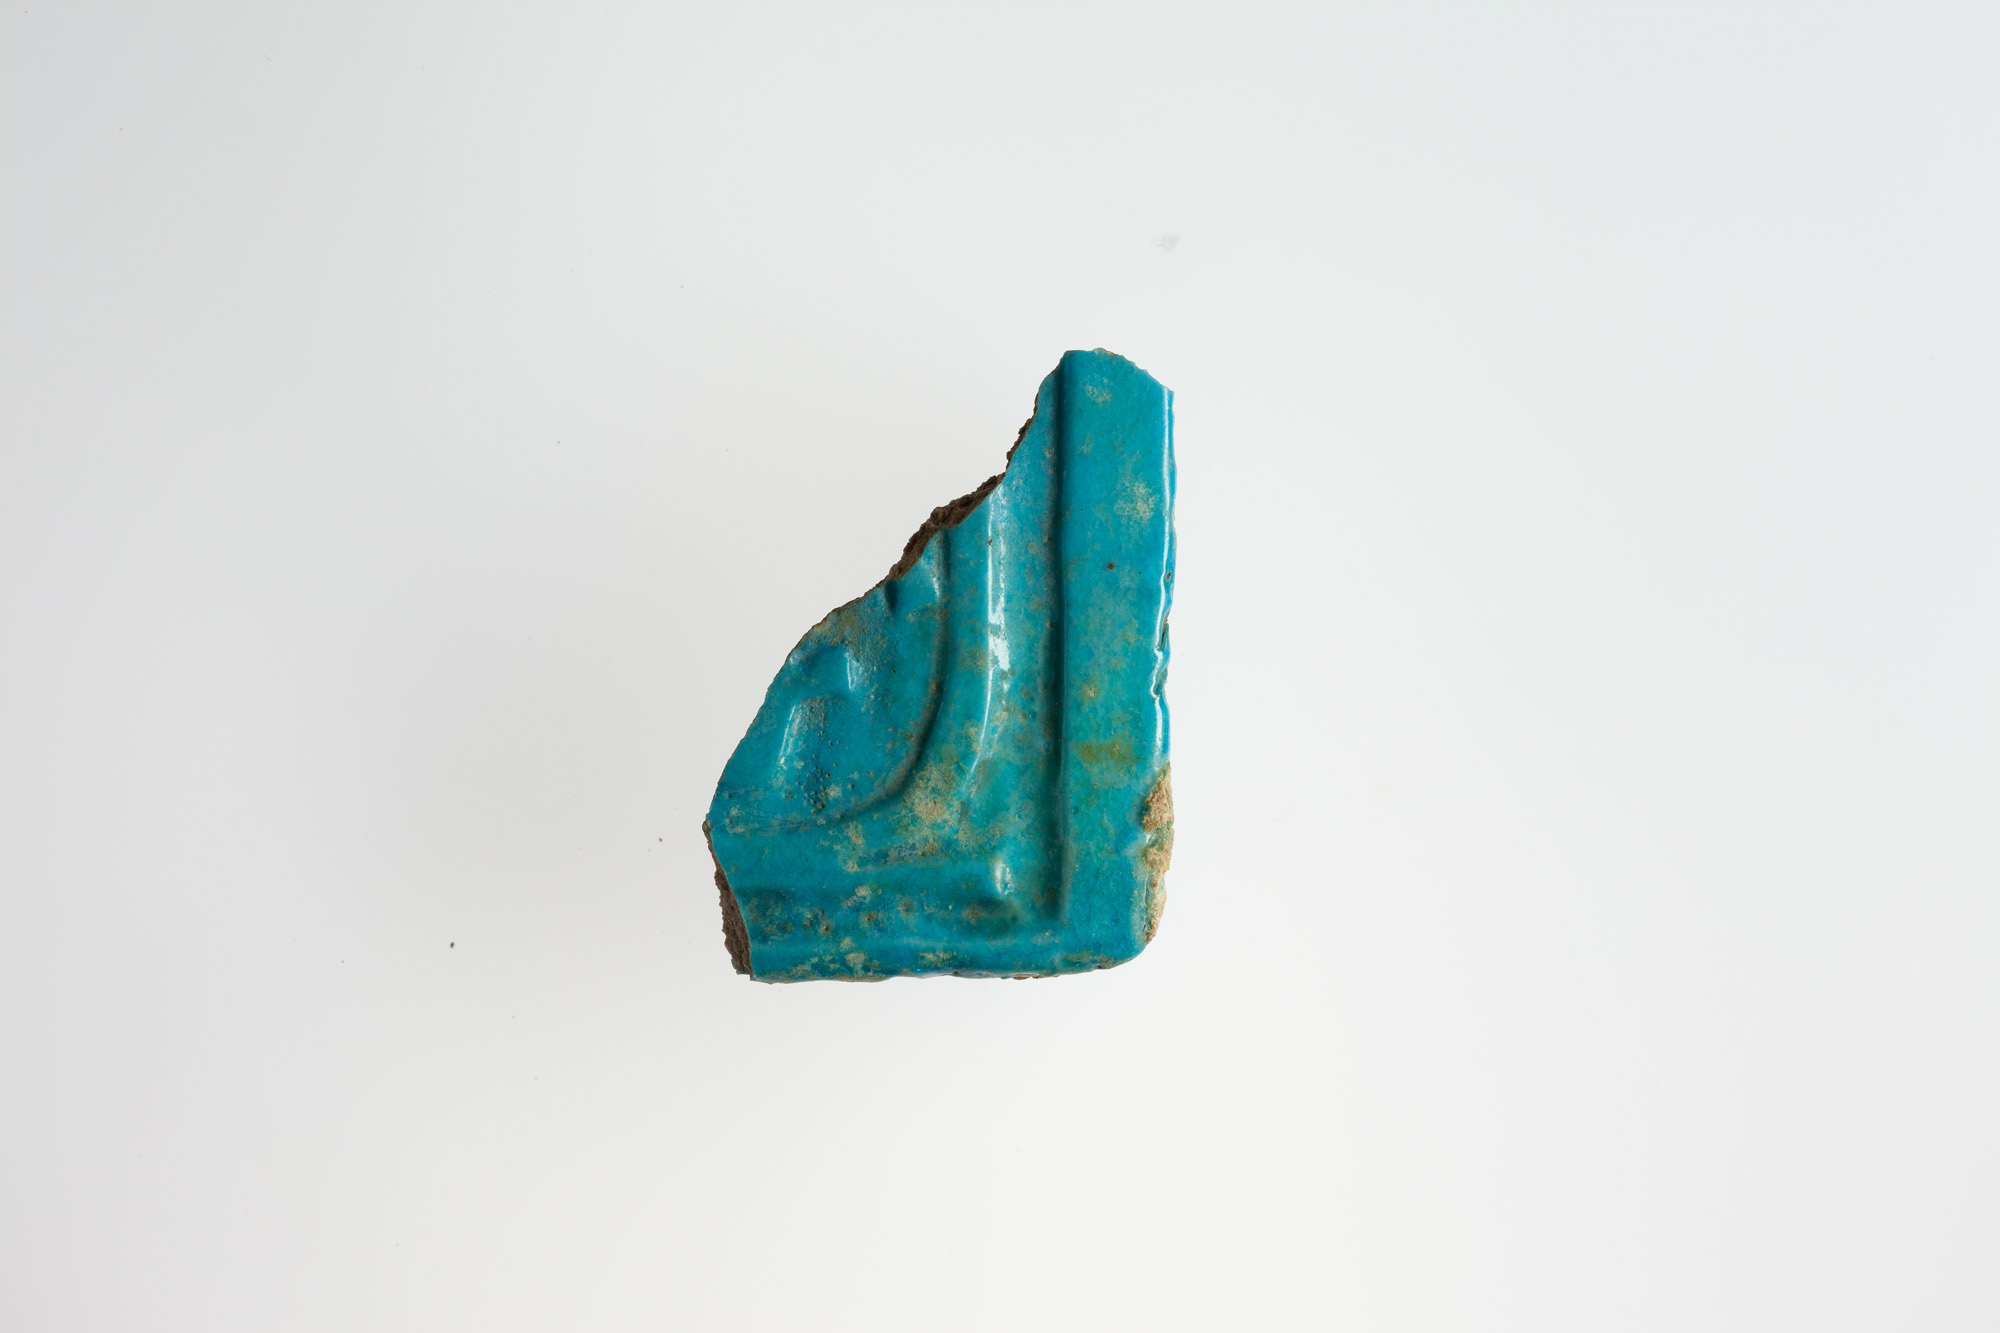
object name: tile fragment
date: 1981-1640 BCE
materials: faience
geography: egypt